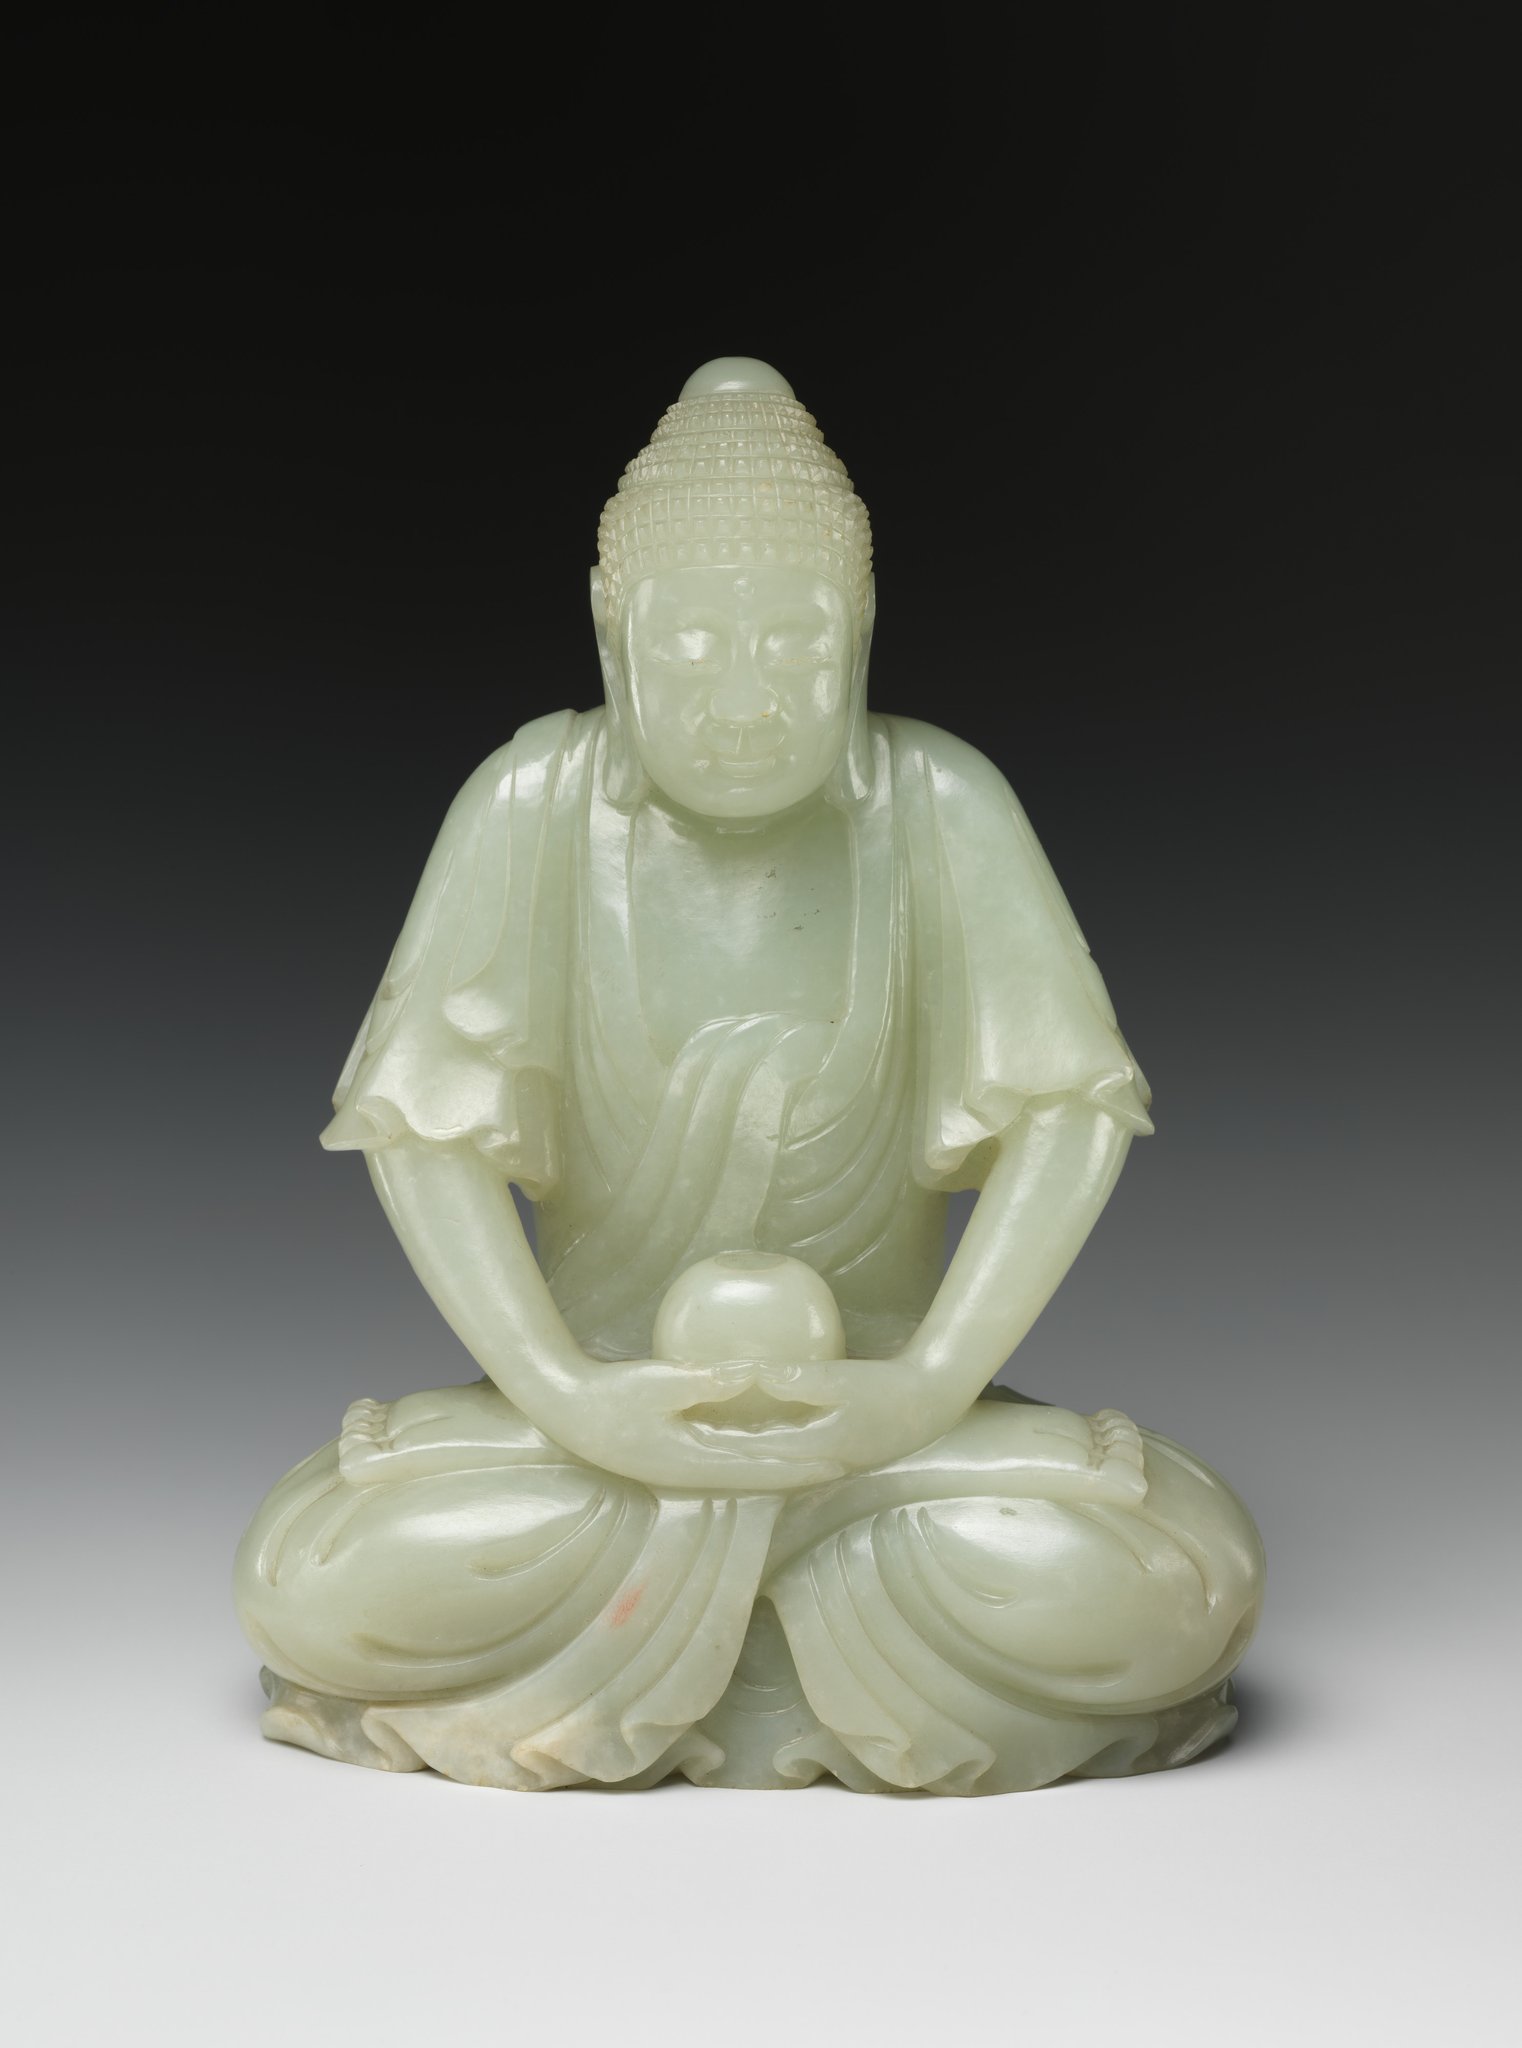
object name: figure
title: Seated Buddha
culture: chinese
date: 1701-1800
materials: jade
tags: buddha